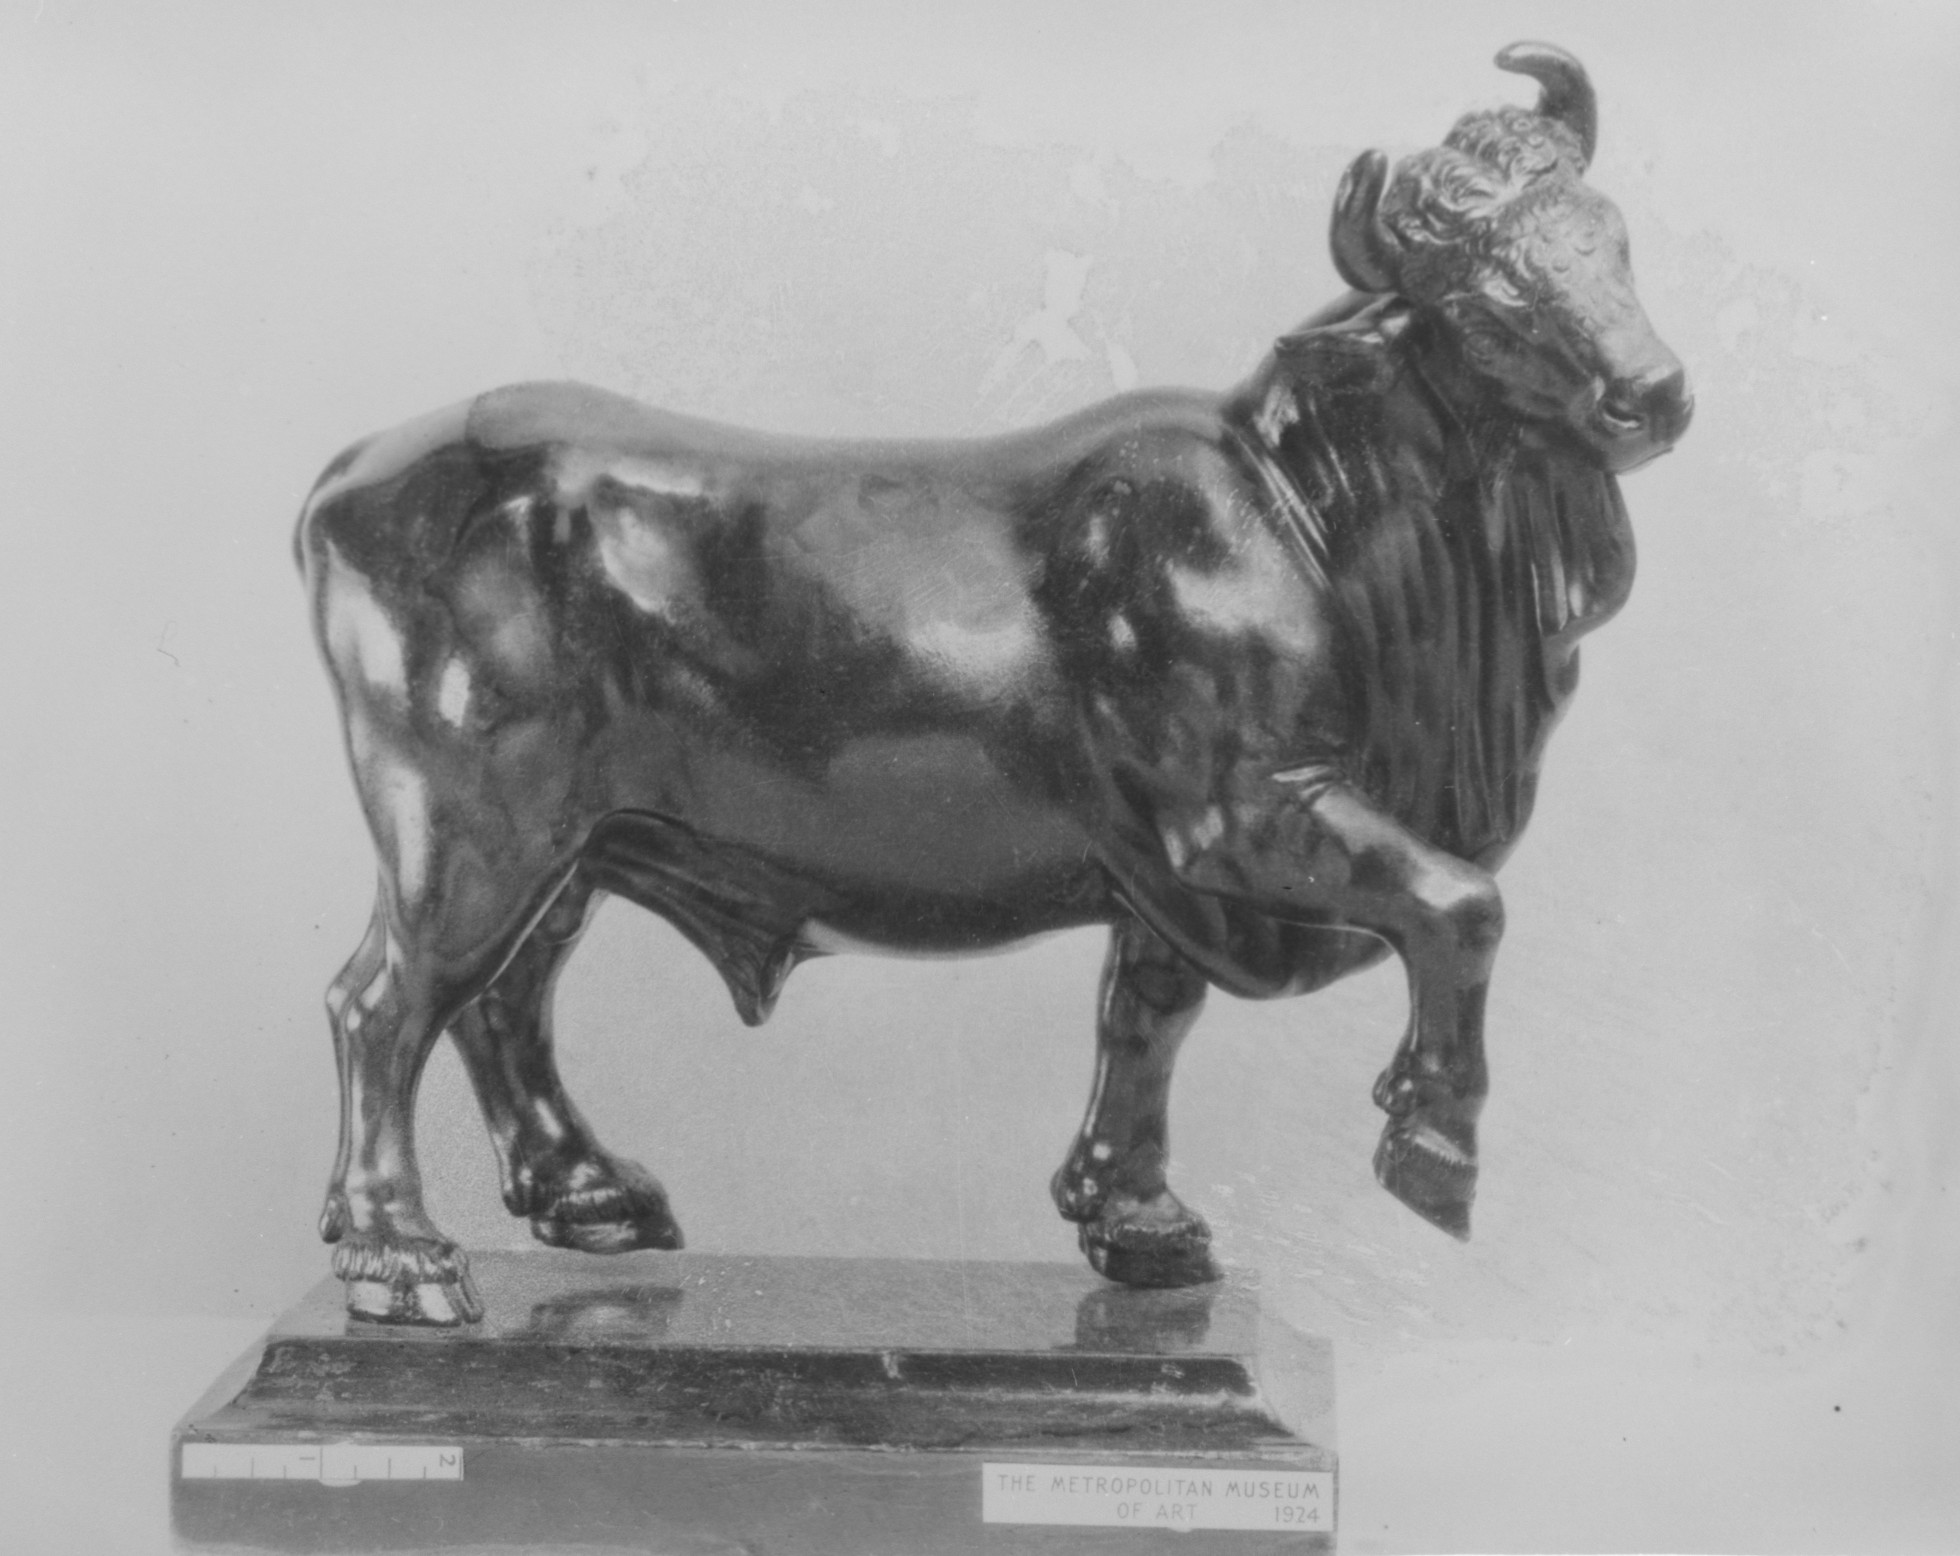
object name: statuette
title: Bull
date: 1601-1800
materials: bronze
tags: bulls